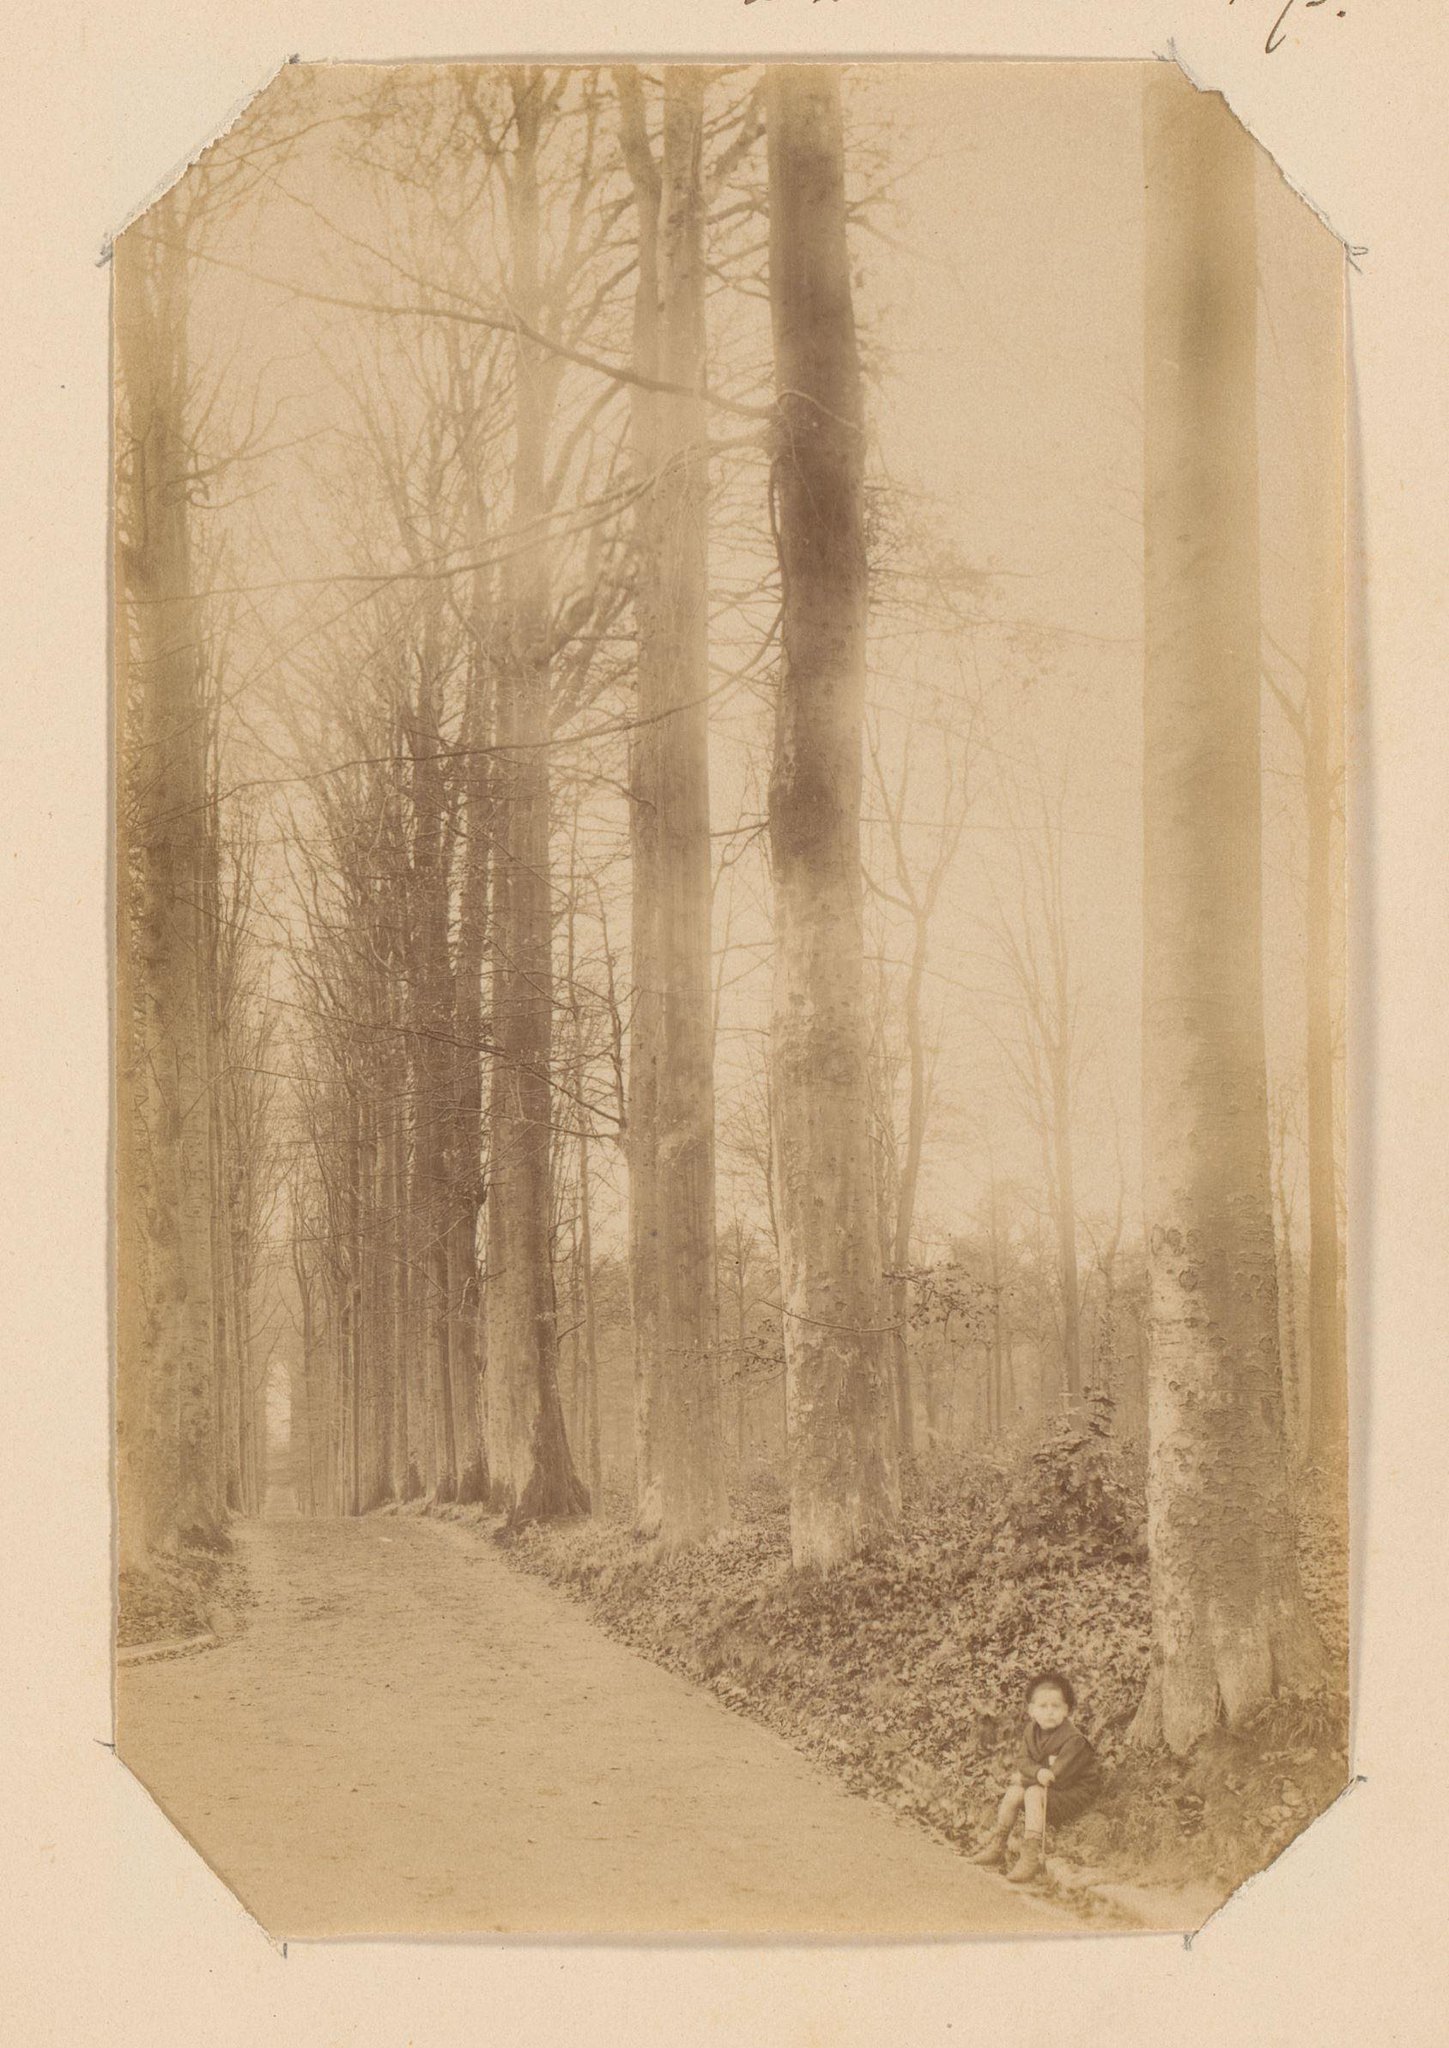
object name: photograph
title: Gezicht op een bospad, met een kleine zittende jongen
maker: Anonymous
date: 1860-1900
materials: photographic support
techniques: albumen print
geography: netherlands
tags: standing figure, boy (child between toddler and youth), forest path or lane (+ landscape with figures, staffage)